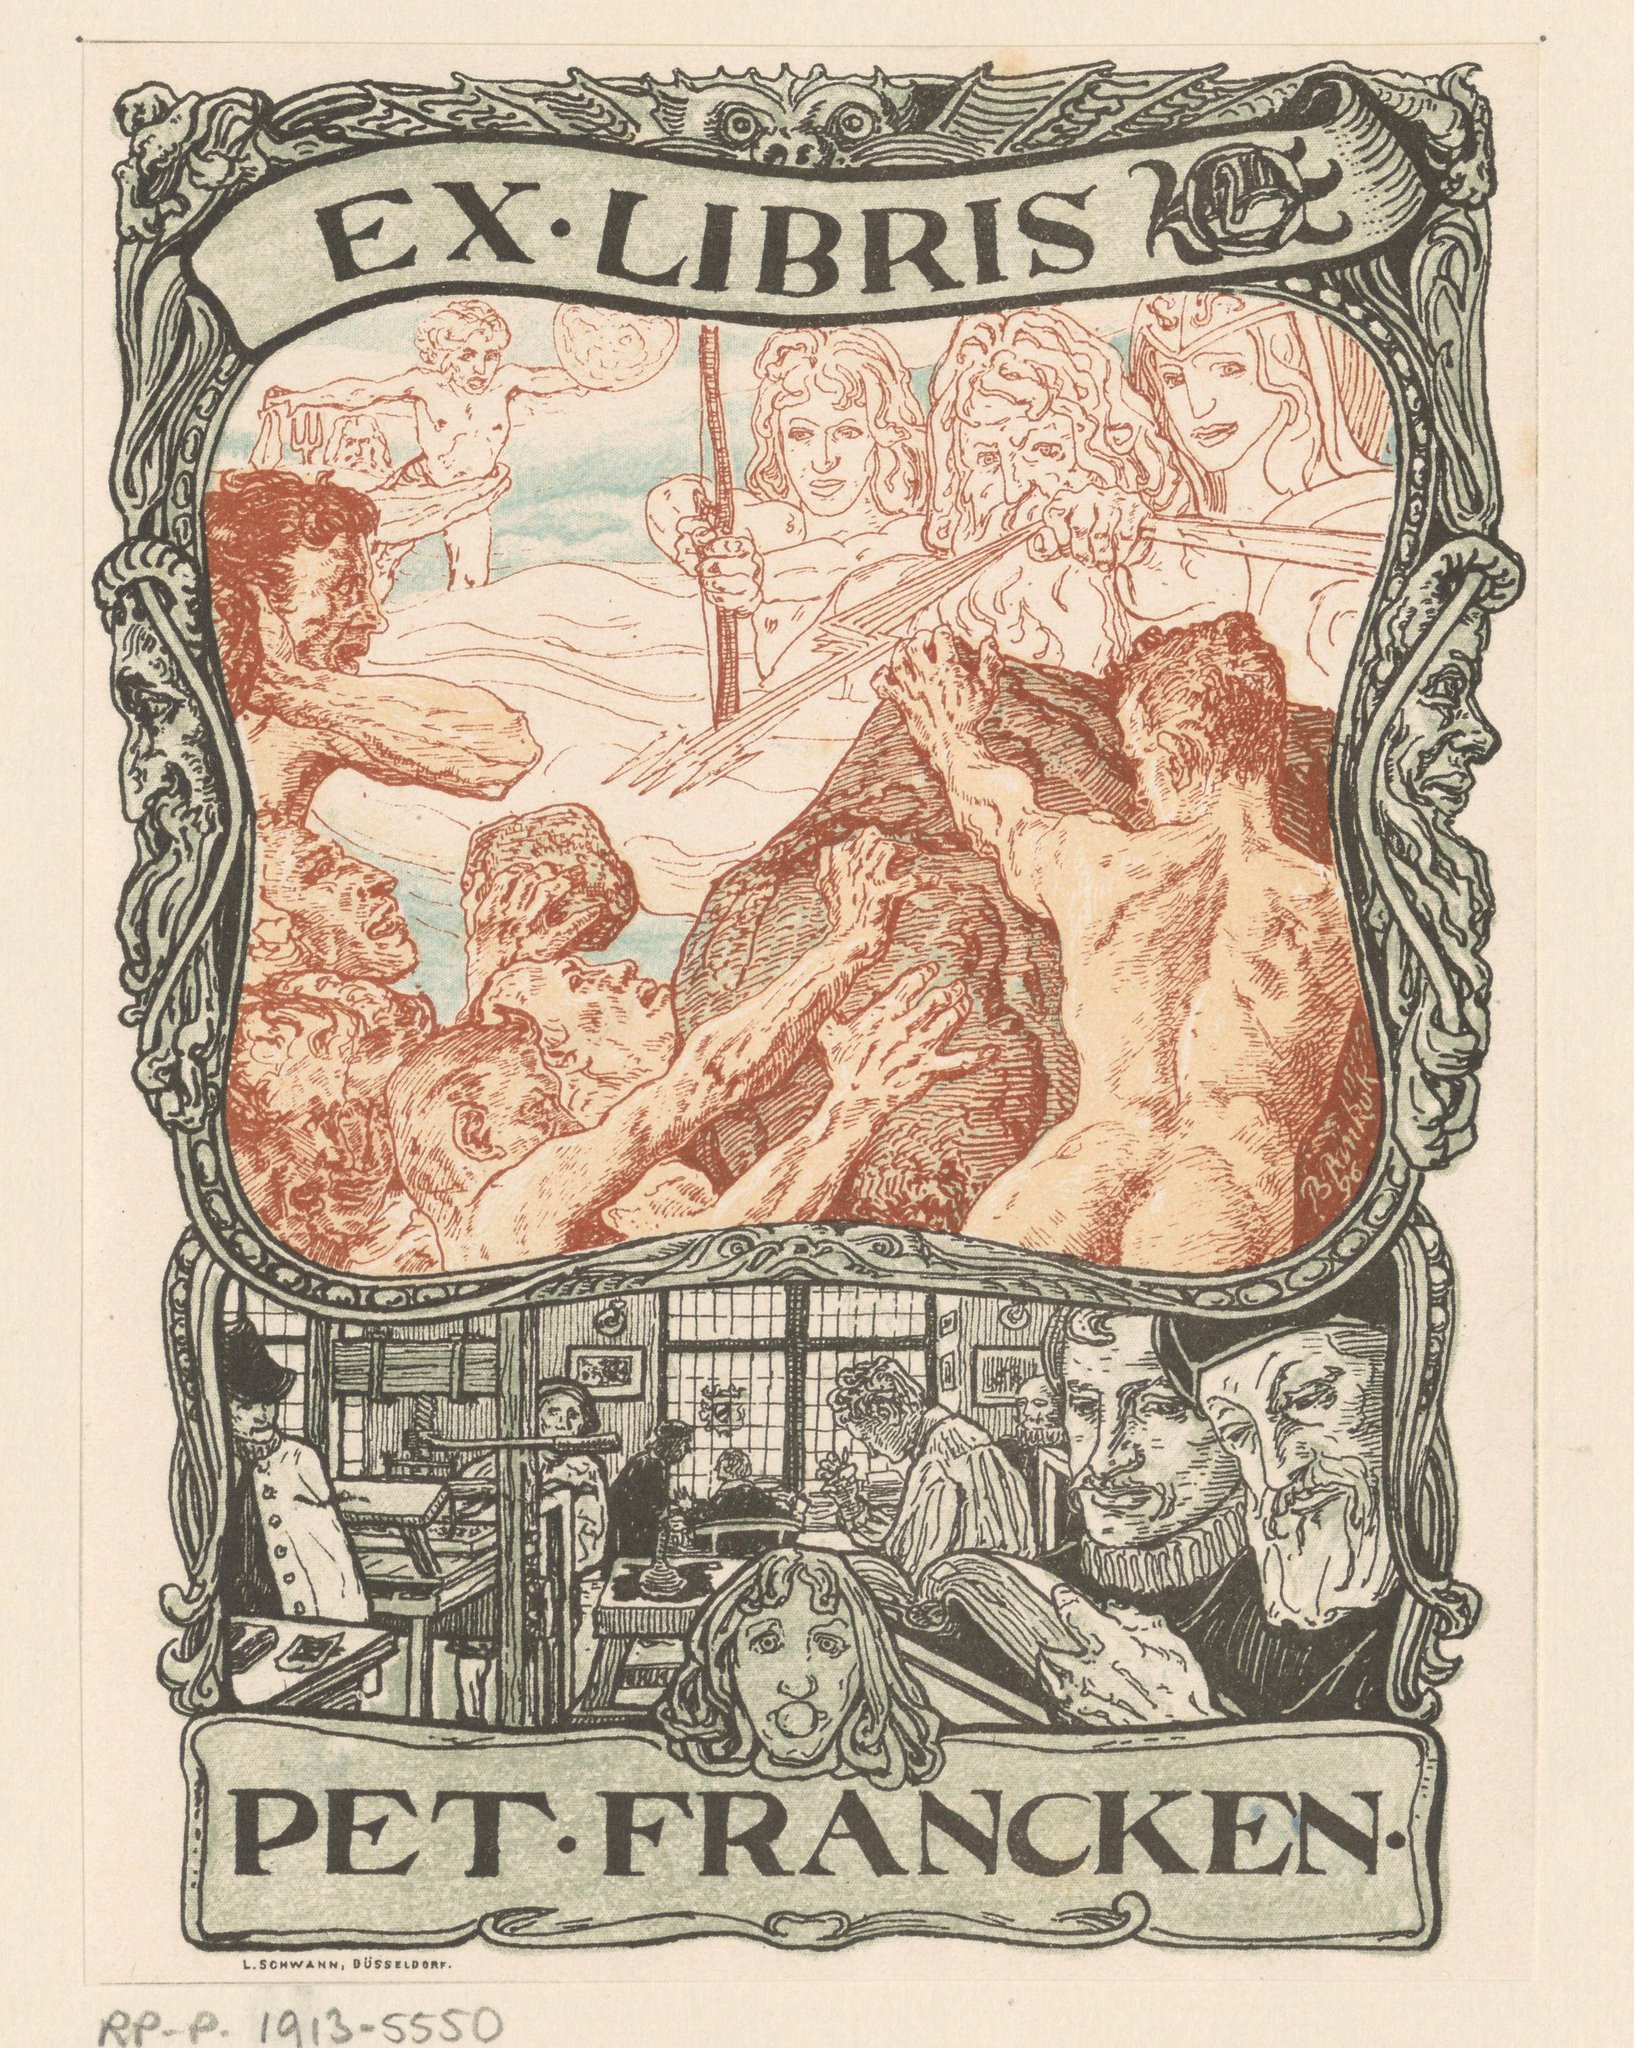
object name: photomechanical print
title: Ex libris van Pet Francken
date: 1896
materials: paper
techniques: printing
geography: germany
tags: reading, (story of) jupiter (zeus), printing, printing office, old man, man (showing himself) undressed, quasi-nude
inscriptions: collector's mark: Lugt 2233, collector's mark: Lugt 2760